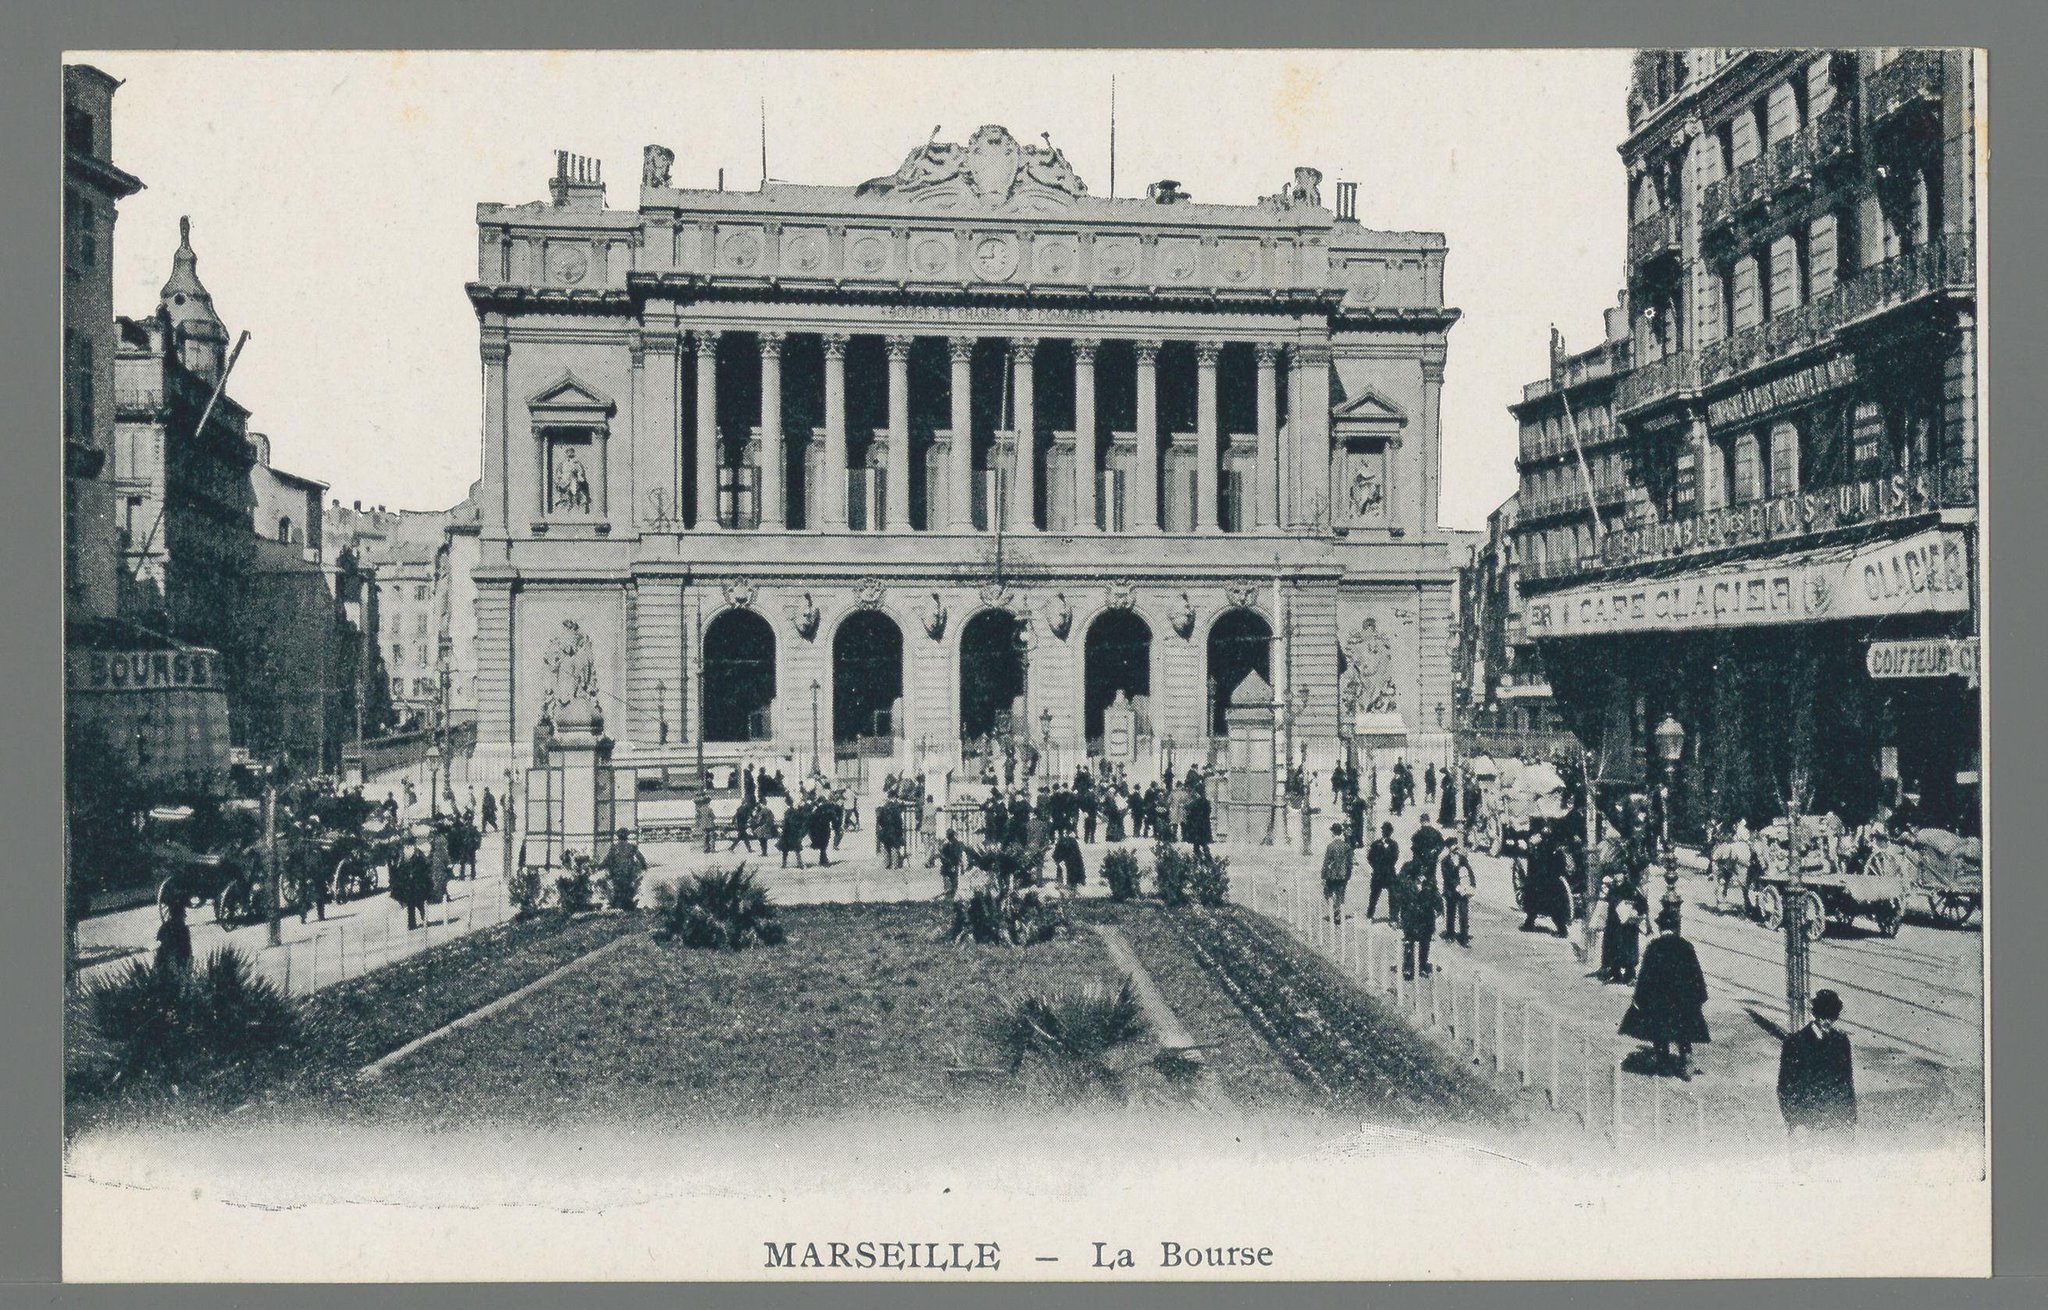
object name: photomechanical print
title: Marseille. La Bourse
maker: Anonymous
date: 1904-1906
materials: cardboard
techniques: autotype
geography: marseille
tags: exchange, bourse, square, place, circus, etc. (+ city(-scape) with figures, staffage), marseille